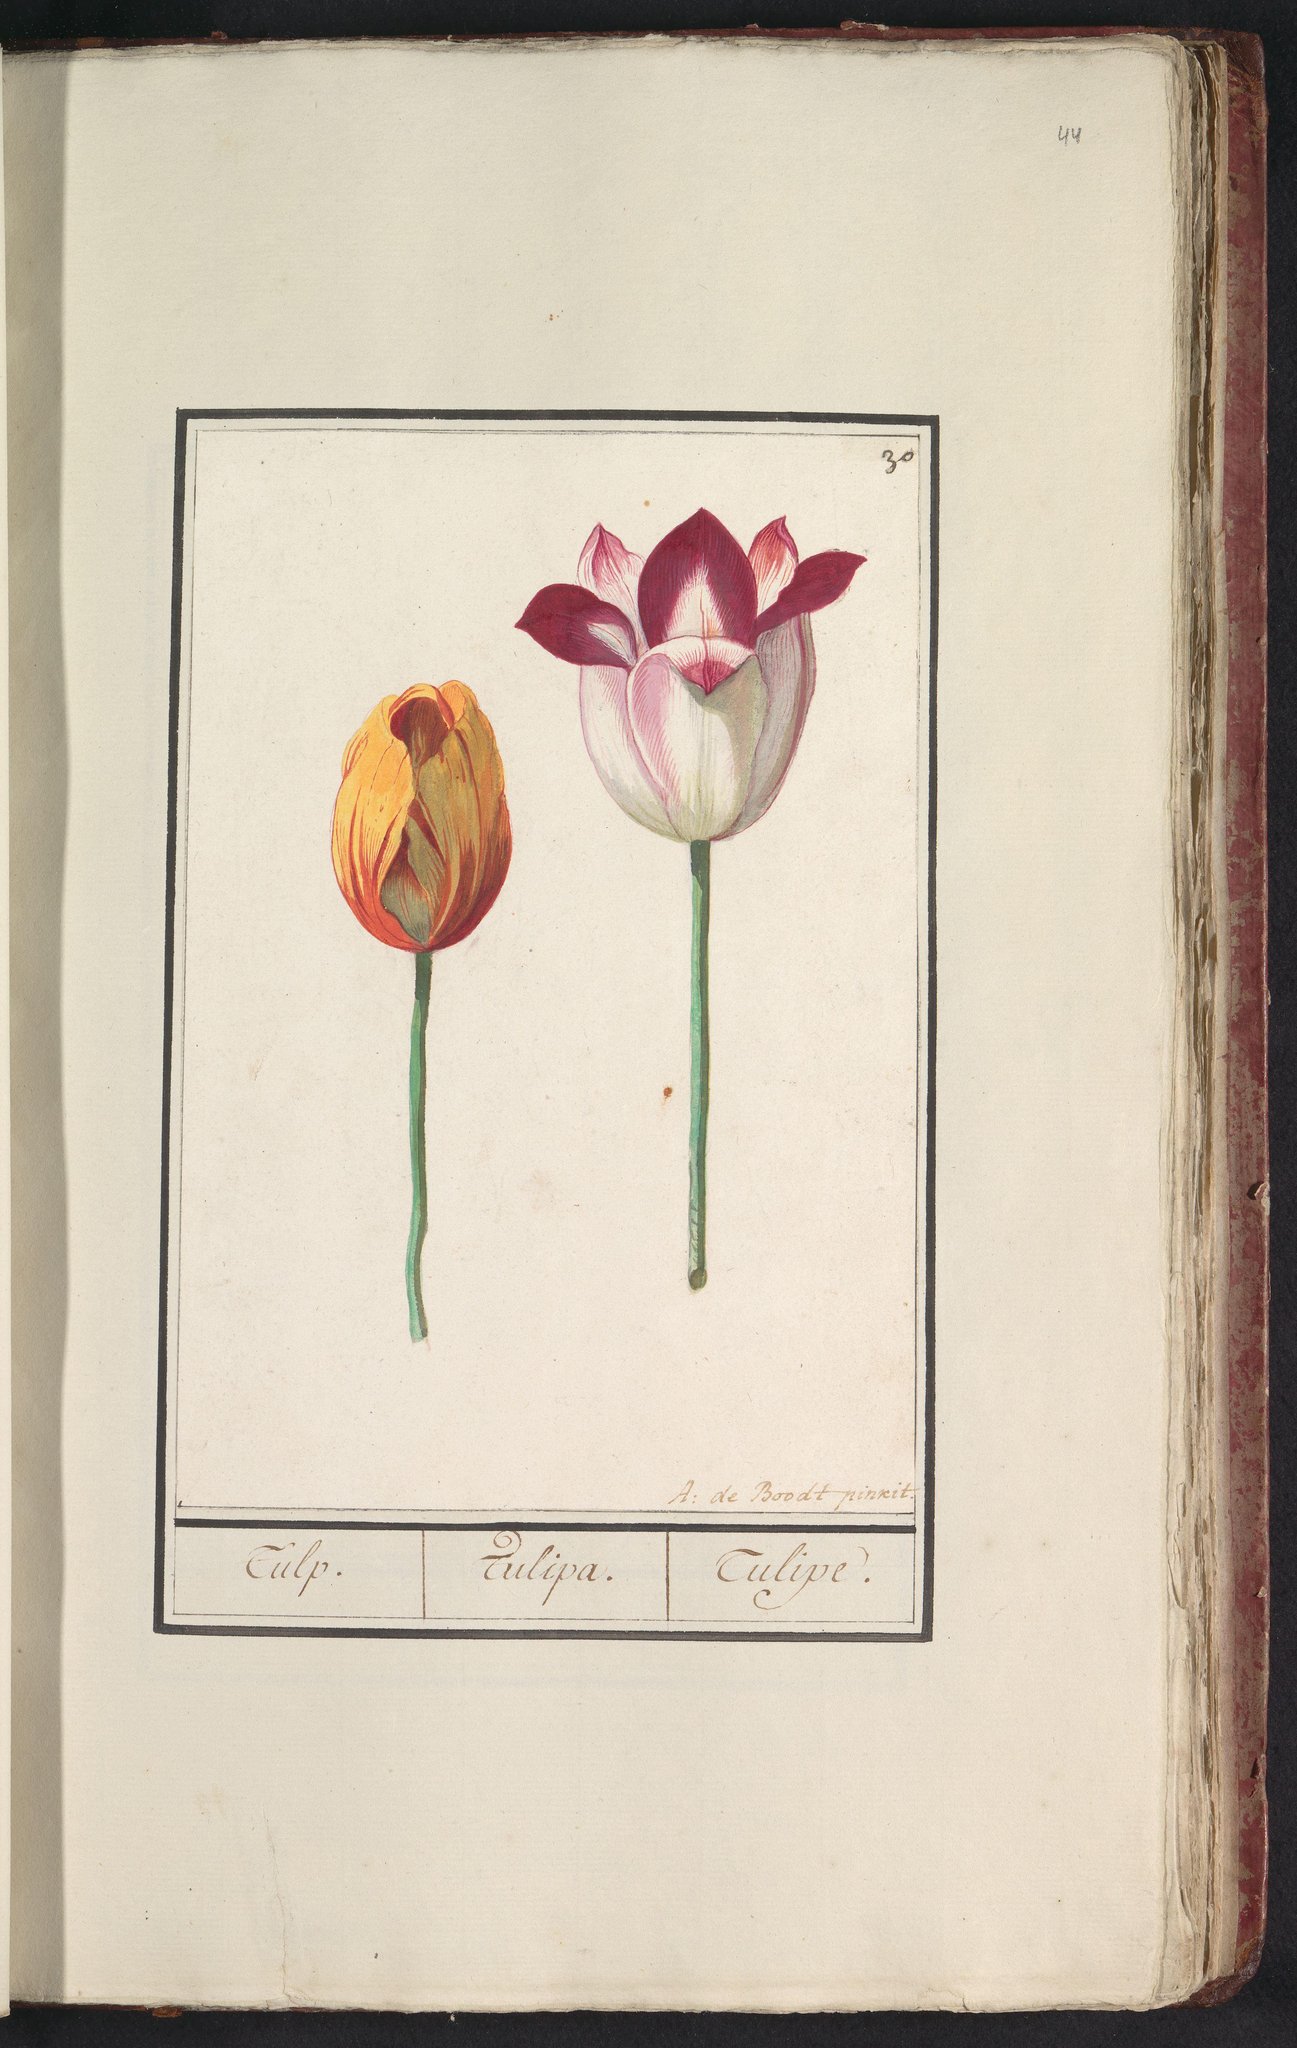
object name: drawing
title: Tulp. / Tulipa. / Tulipe.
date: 1596-1610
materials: chalk, paint, paper, watercolor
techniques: brush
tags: flowers: tulip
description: Rood-gele en een rood-witte tulp. Genummerd rechtsboven: 30. Onderdeel van het eerste album met tekeningen van bloemen en planten. Achtste van twaalf albums met tekeningen van dieren, vogels en planten bekend rond 1600, gemaakt in opdracht van keizer Rudolf II. Met toelichting in Nederlands, Latijn en Frans.